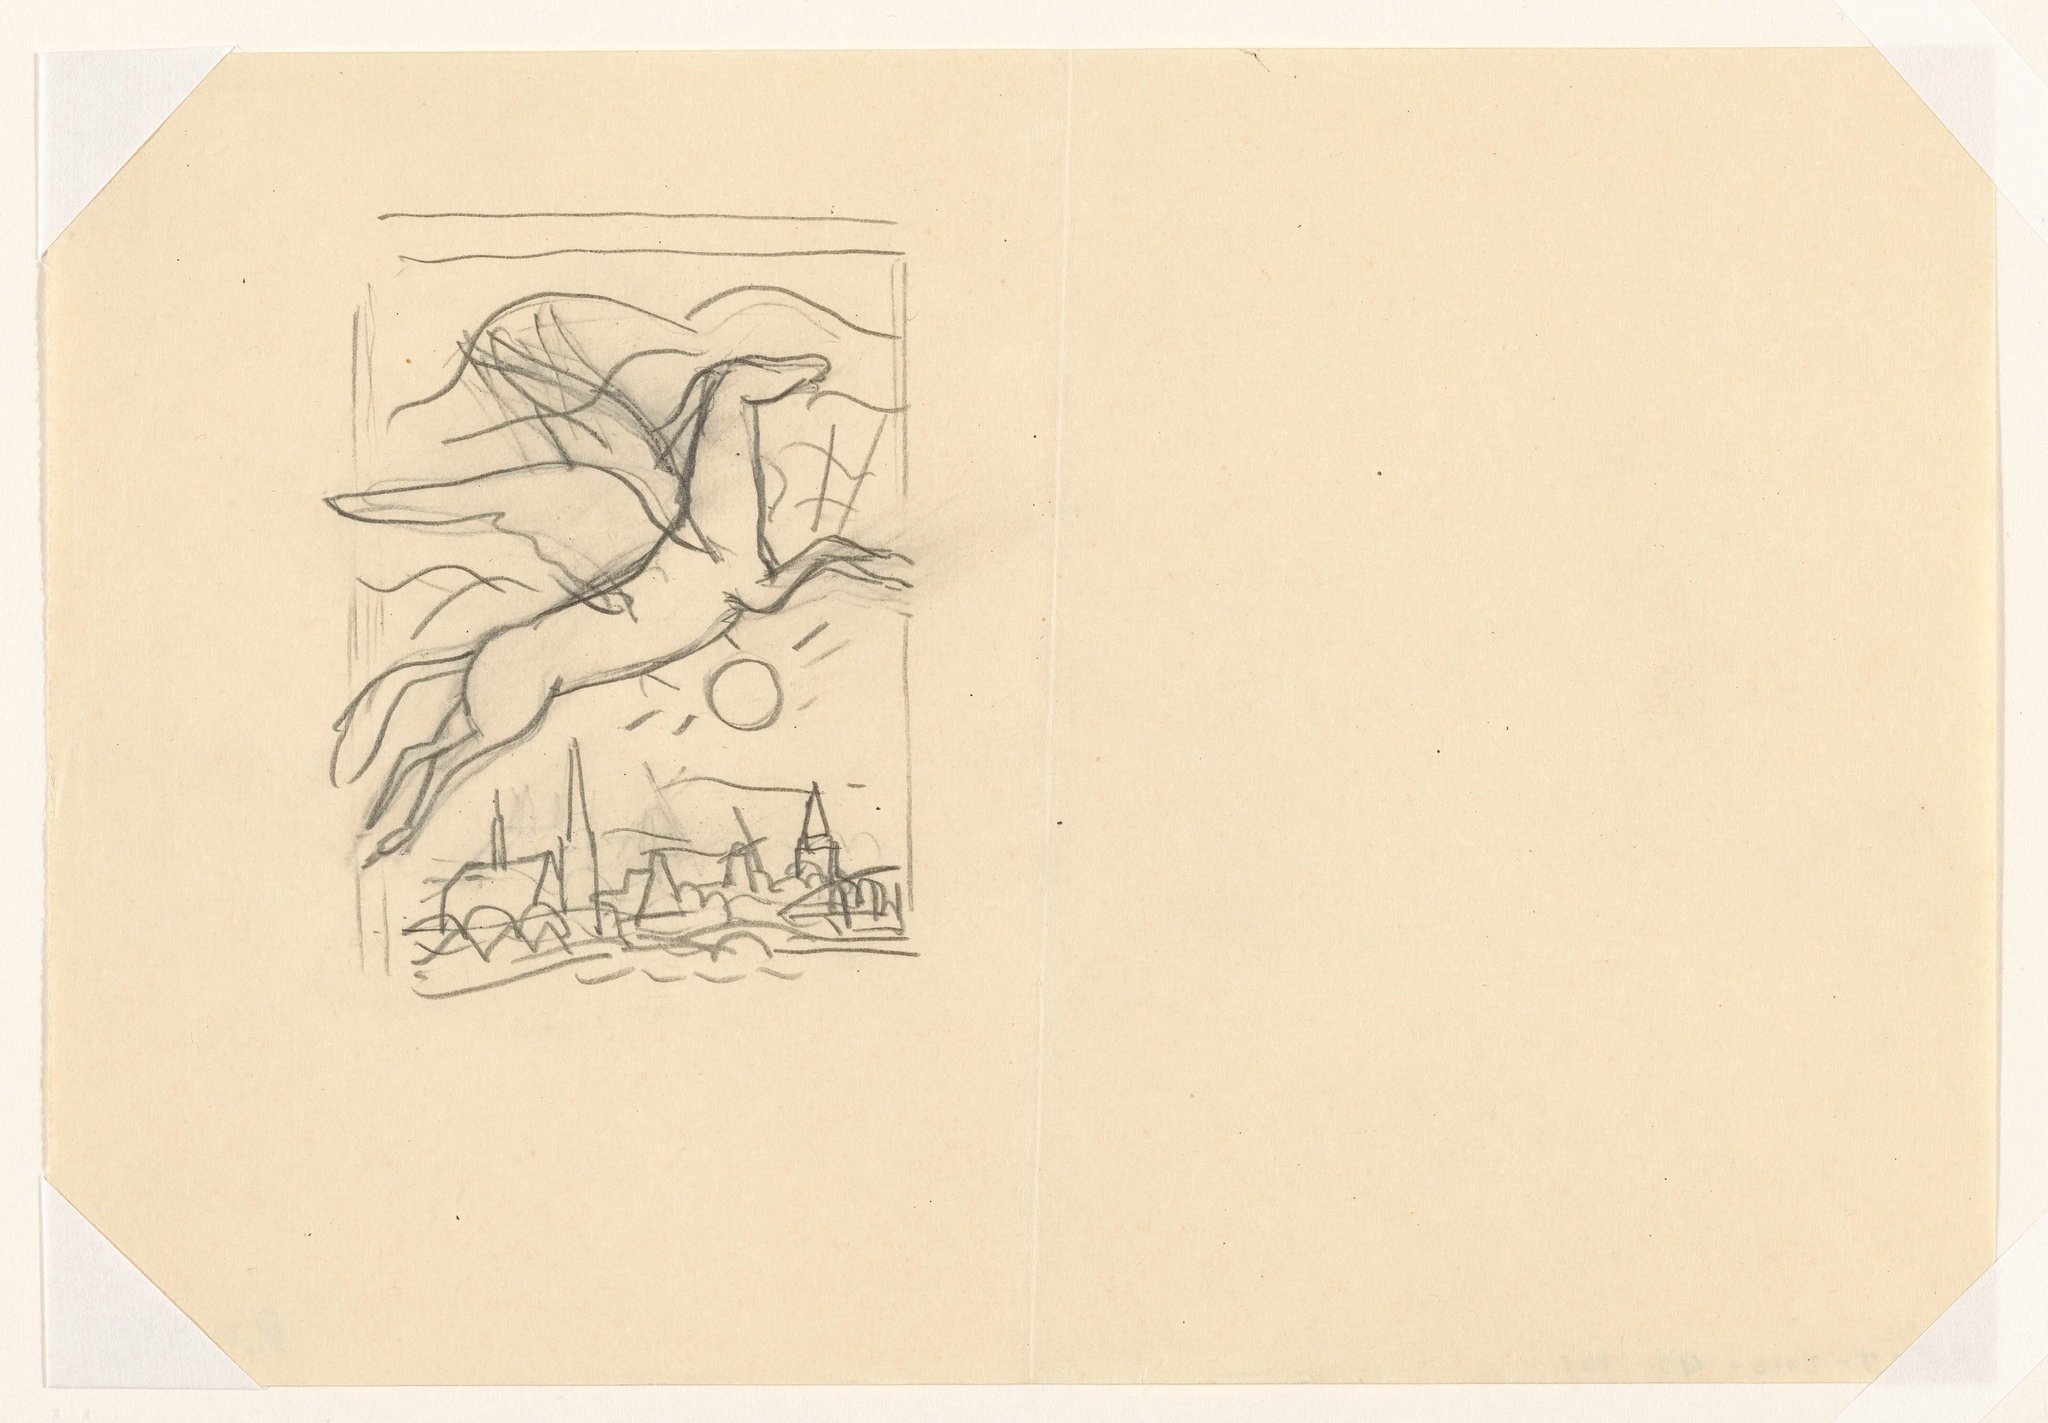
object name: bookplate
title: Ex libris voor J. Slagter (ontwerp)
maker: leo gestel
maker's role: draughtsman, print maker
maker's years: 1881-1941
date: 1935-1940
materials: paper, pencil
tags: j. slagter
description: Vliegend paard met eronder aan de lage horizon het gezicht op een stad. Het blad is in het midden gevouwen.